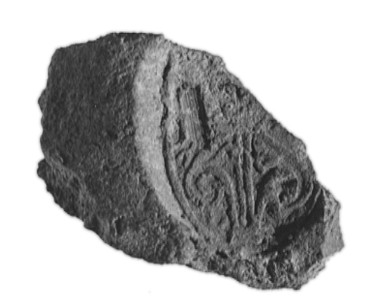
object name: sealing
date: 2030-1640 BCE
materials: clay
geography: egypt